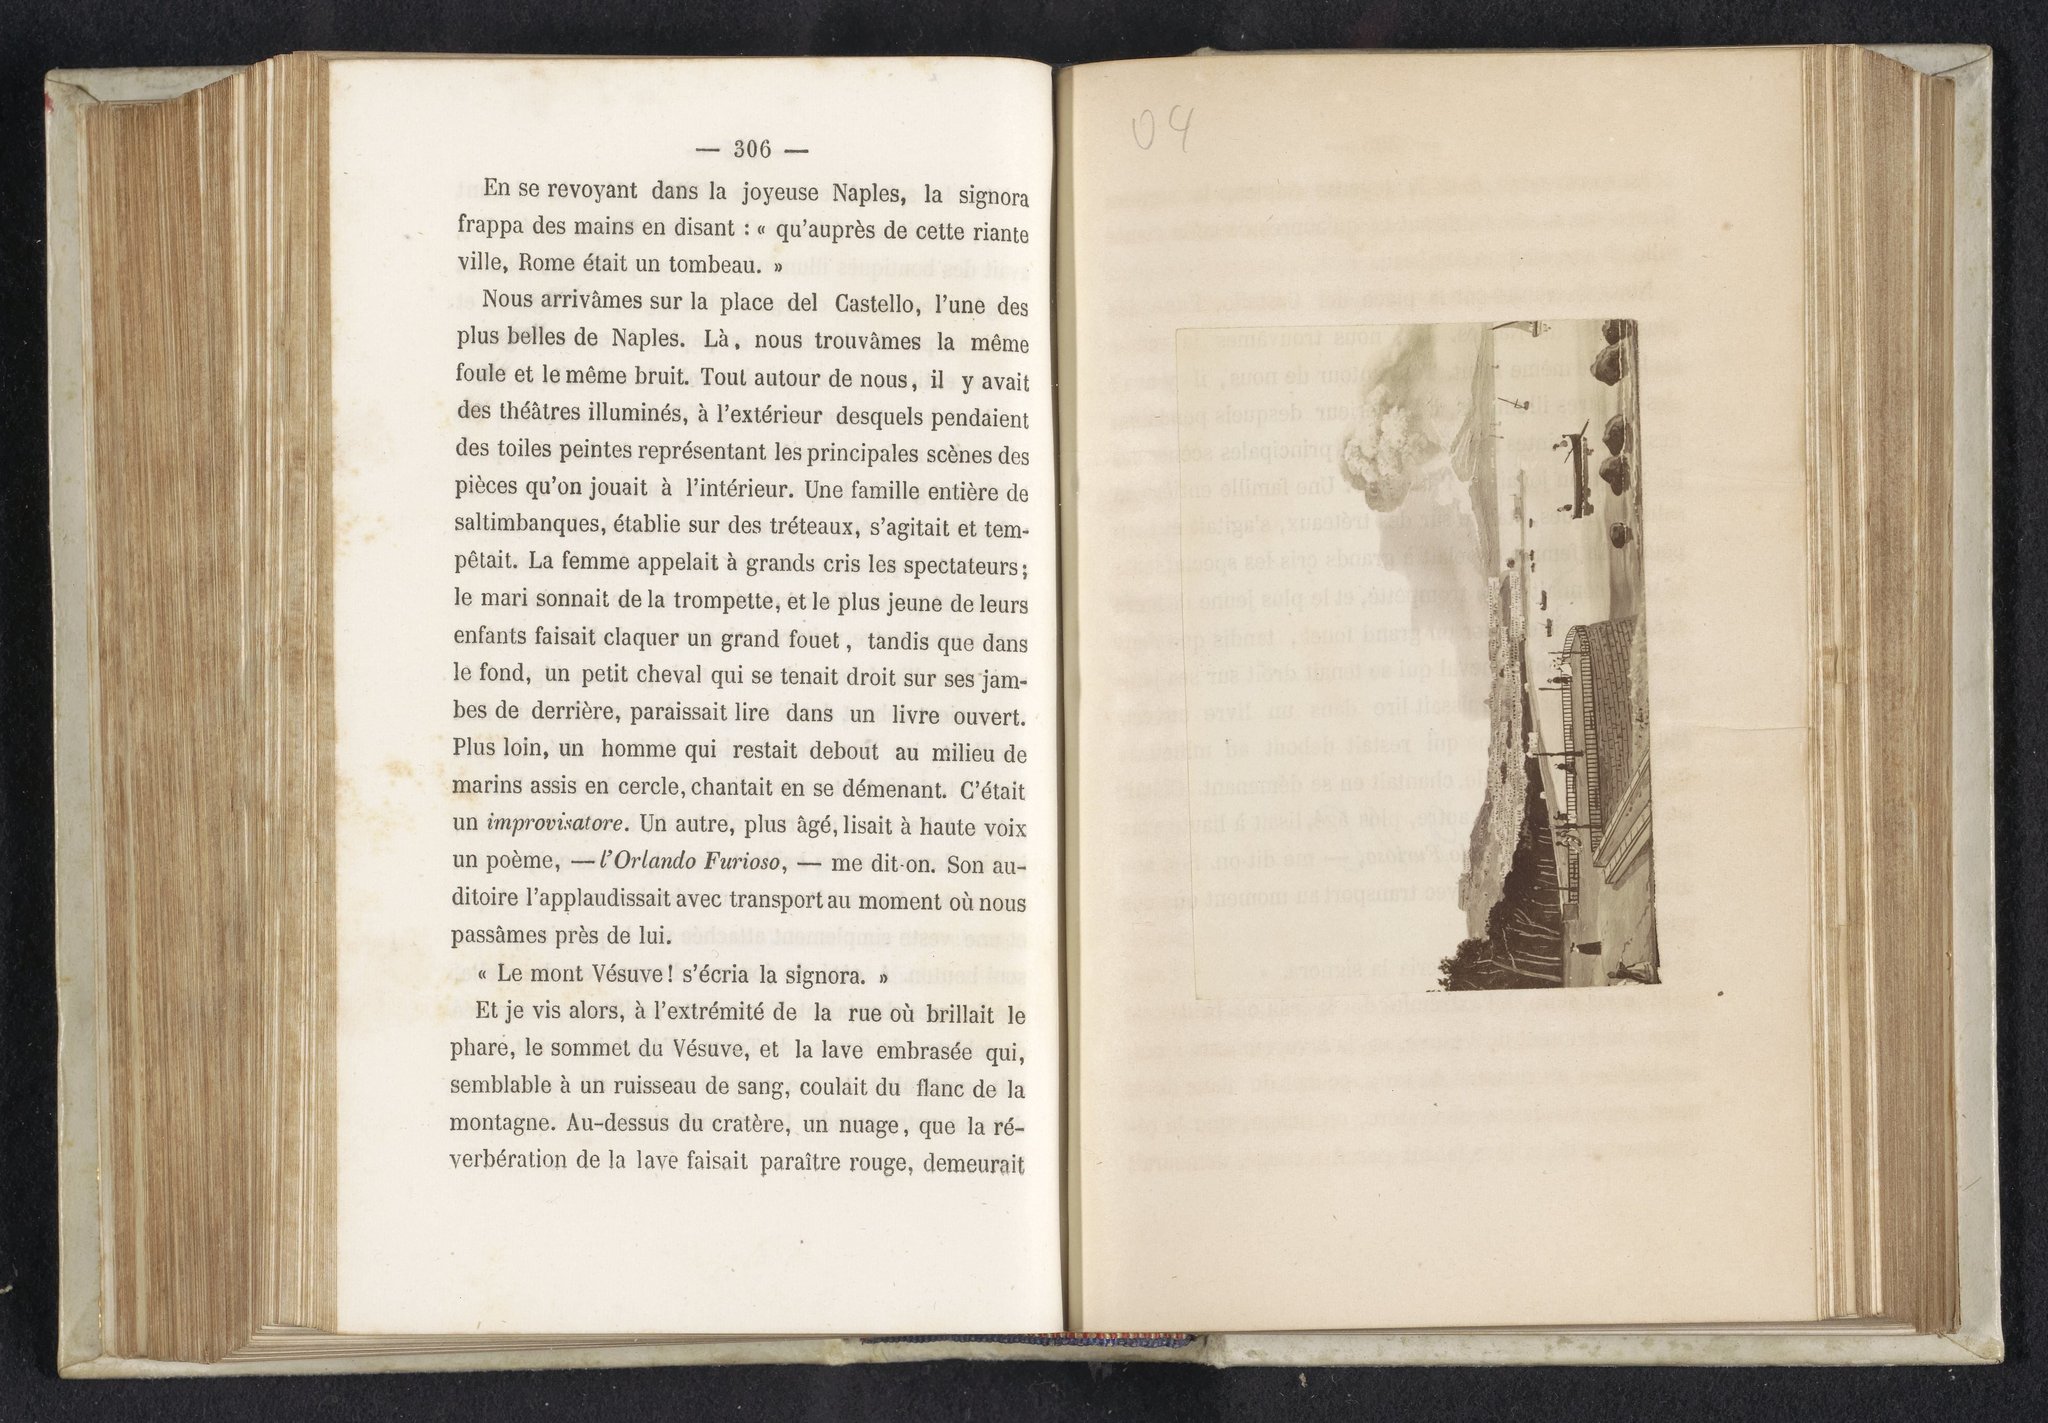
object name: photograph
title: Fotoreproductie van een schilderij, voorstellende een gezicht op de baai van Napels met op de achtergrond de Vesuvius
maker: Anonymous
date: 1850-1860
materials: photographic support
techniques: albumen print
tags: gulf, bay, eruption (of volcano), mount vesuvius, naples